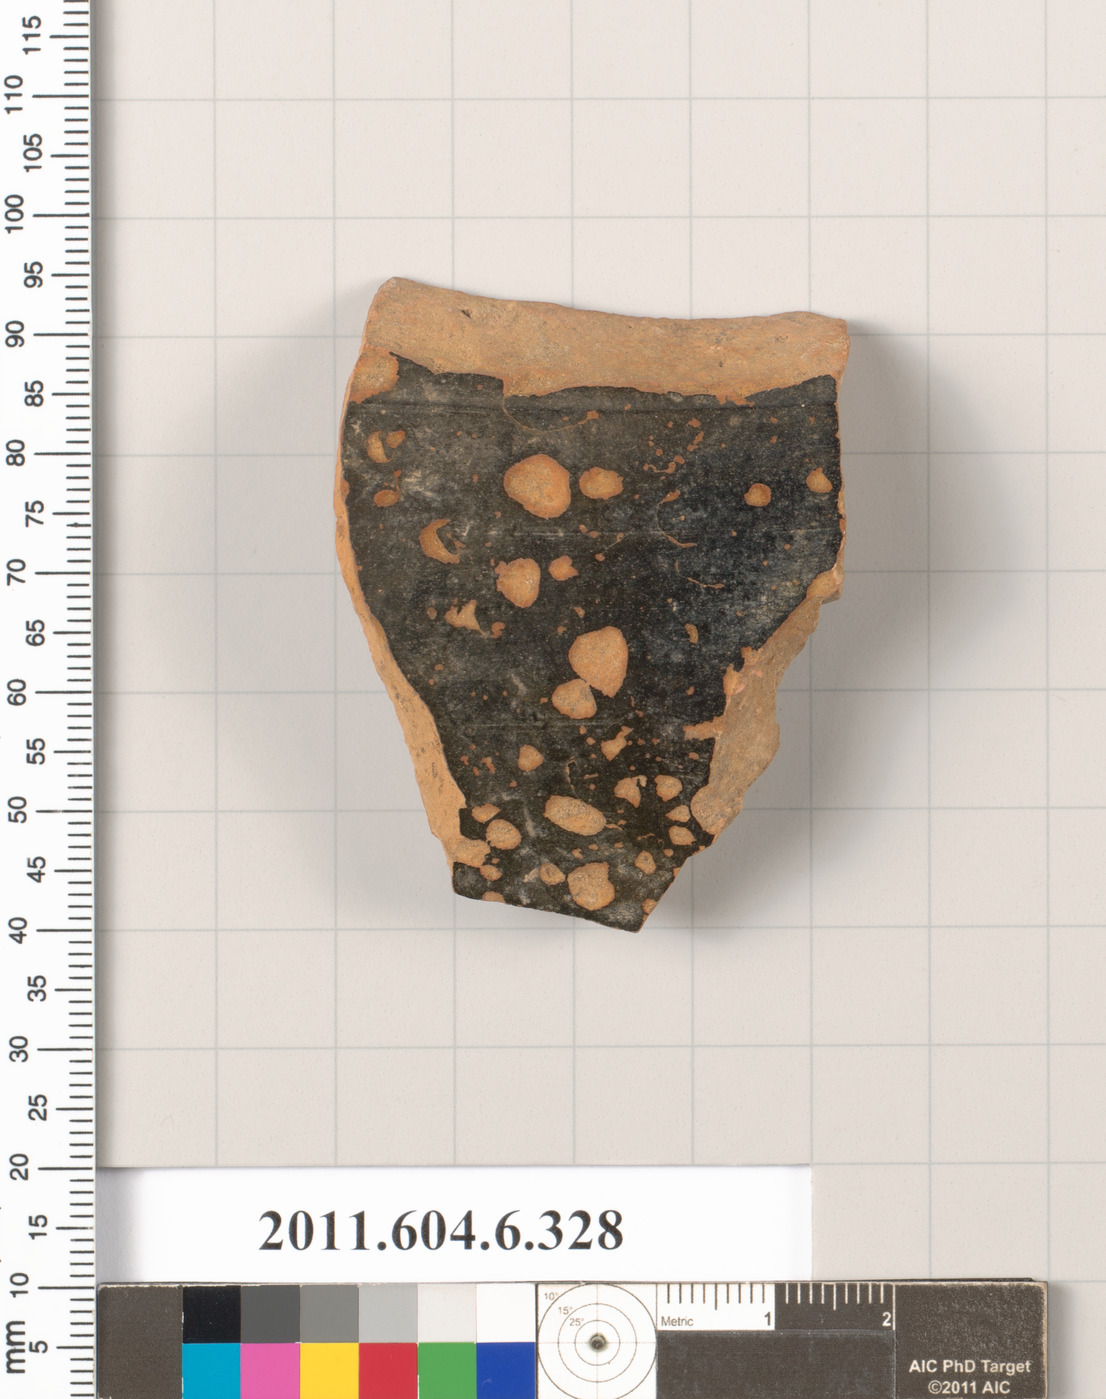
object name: hydria fragment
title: Terracotta fragment of a hydria (water jar)?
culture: greek, attic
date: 600-401 BCE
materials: terracotta